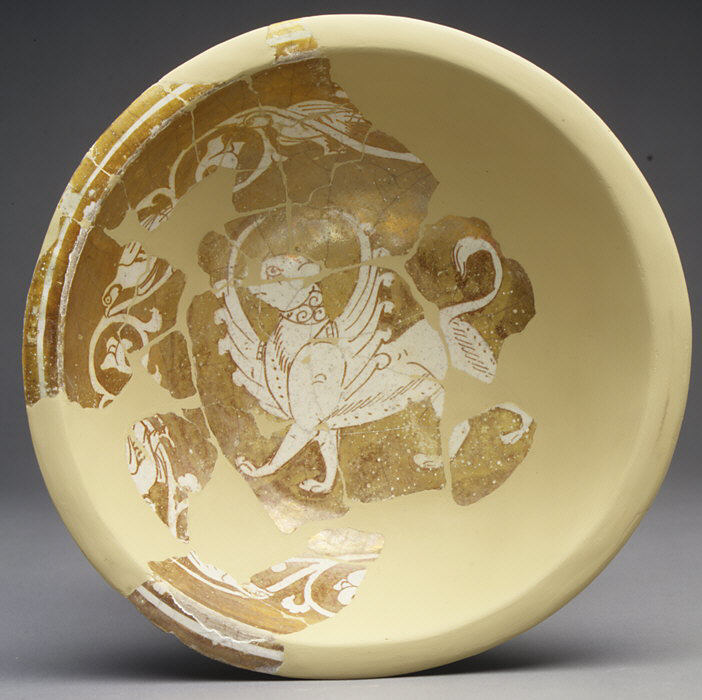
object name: bowl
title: Bowl with Griffin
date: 1001-1100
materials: earthenware, glaze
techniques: luster painting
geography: egypt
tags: griffins